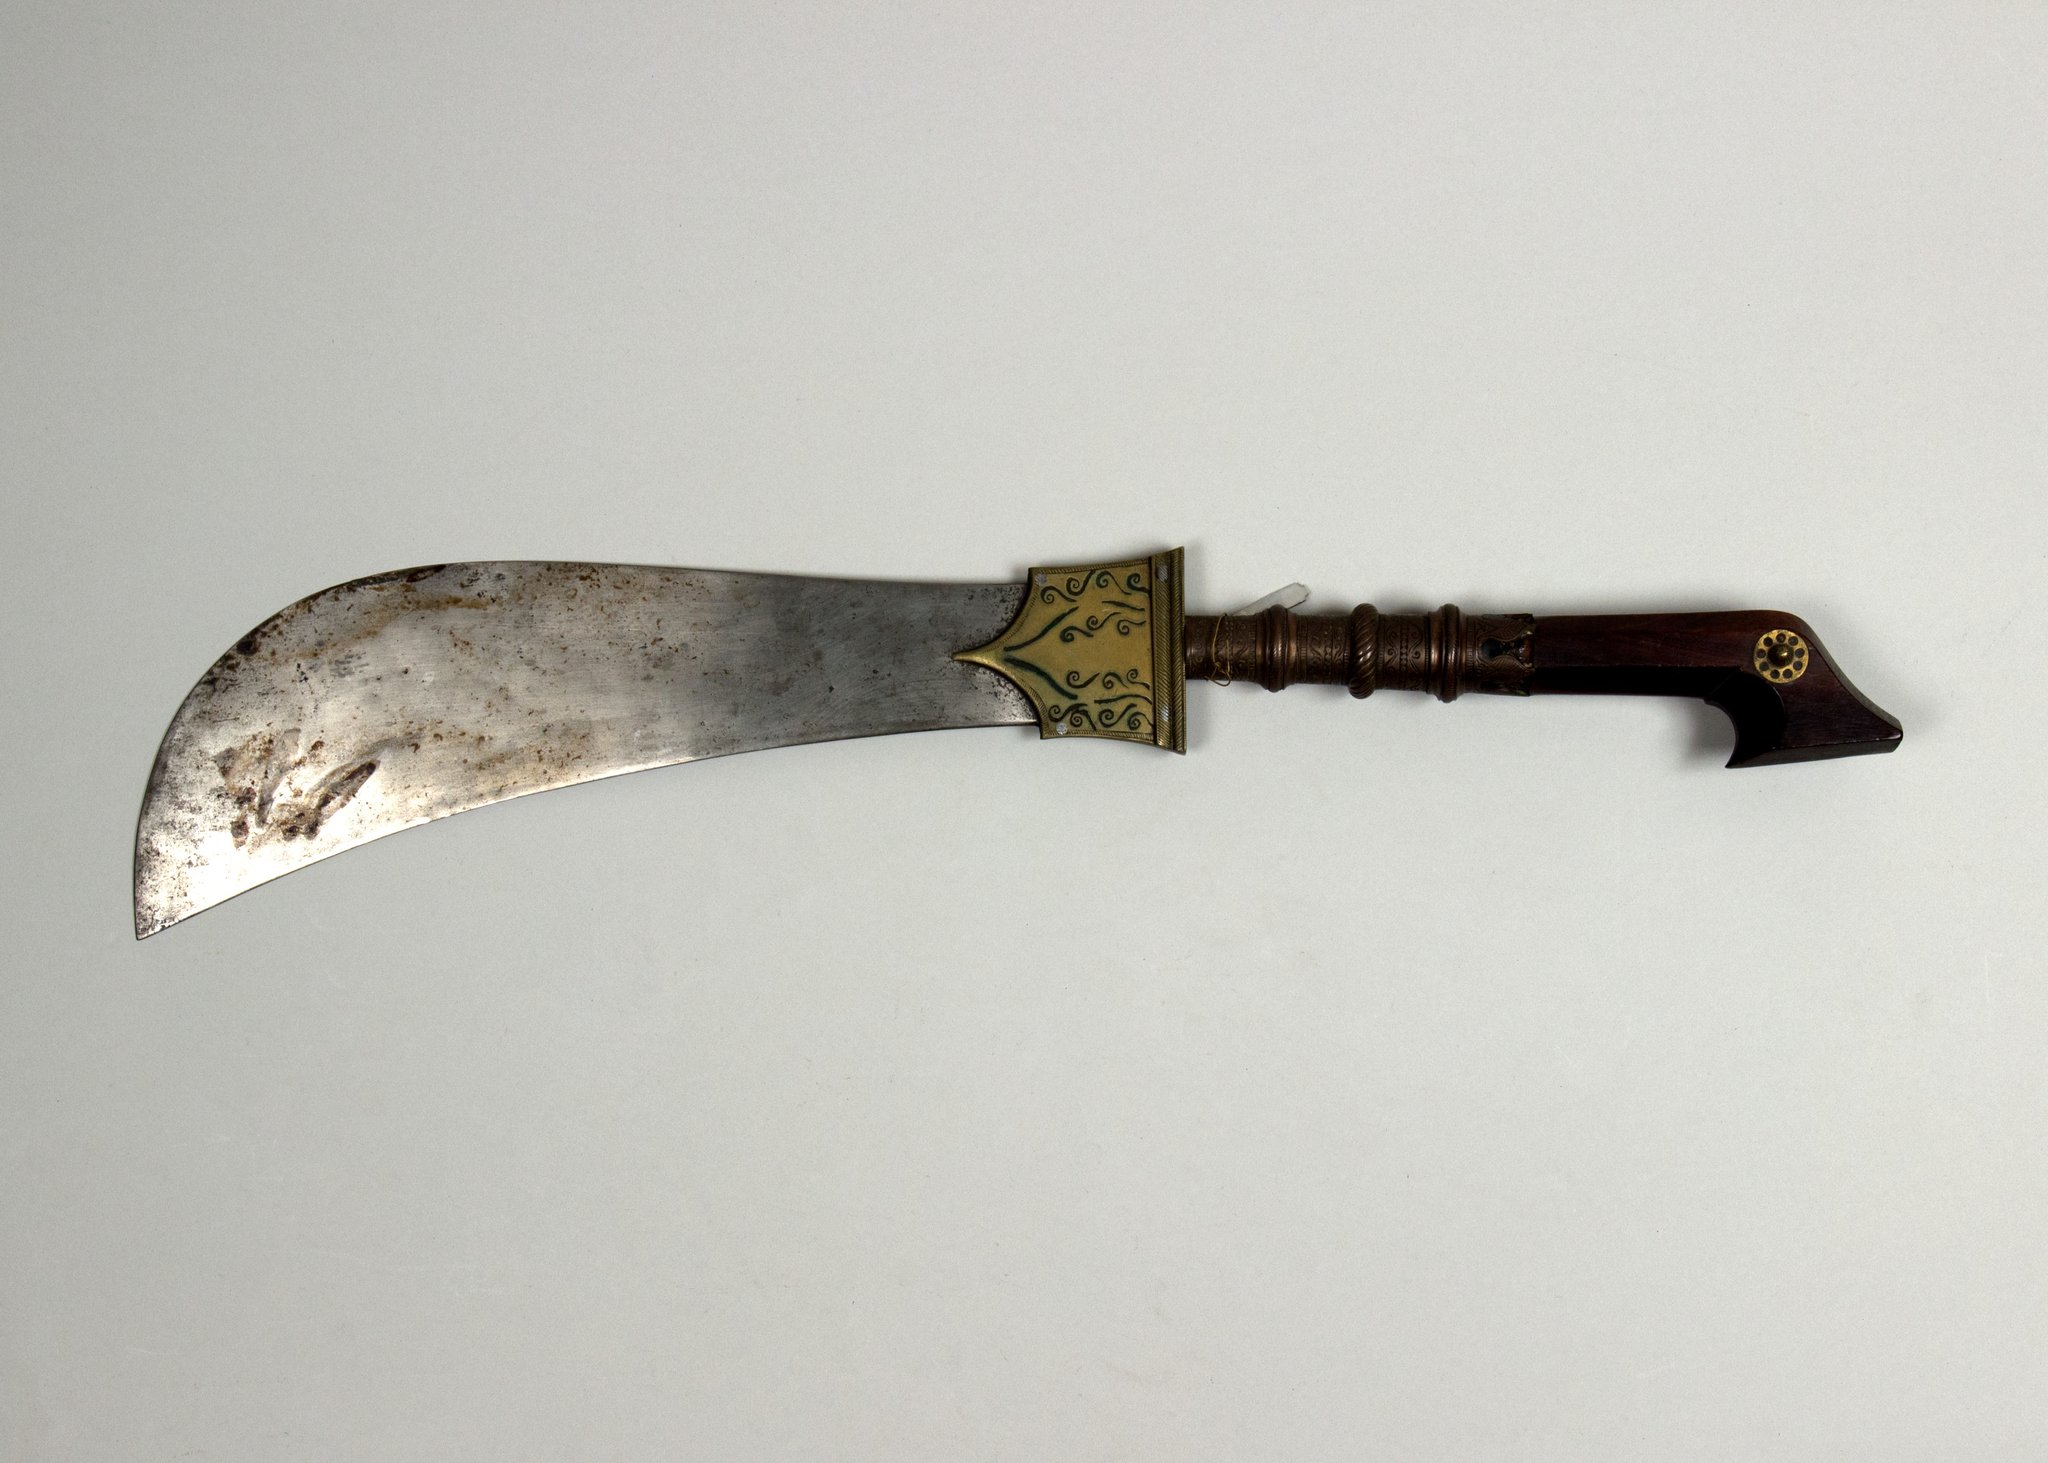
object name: moplah knife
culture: indian, coorg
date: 1701-1900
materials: brass, wood, steel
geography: india